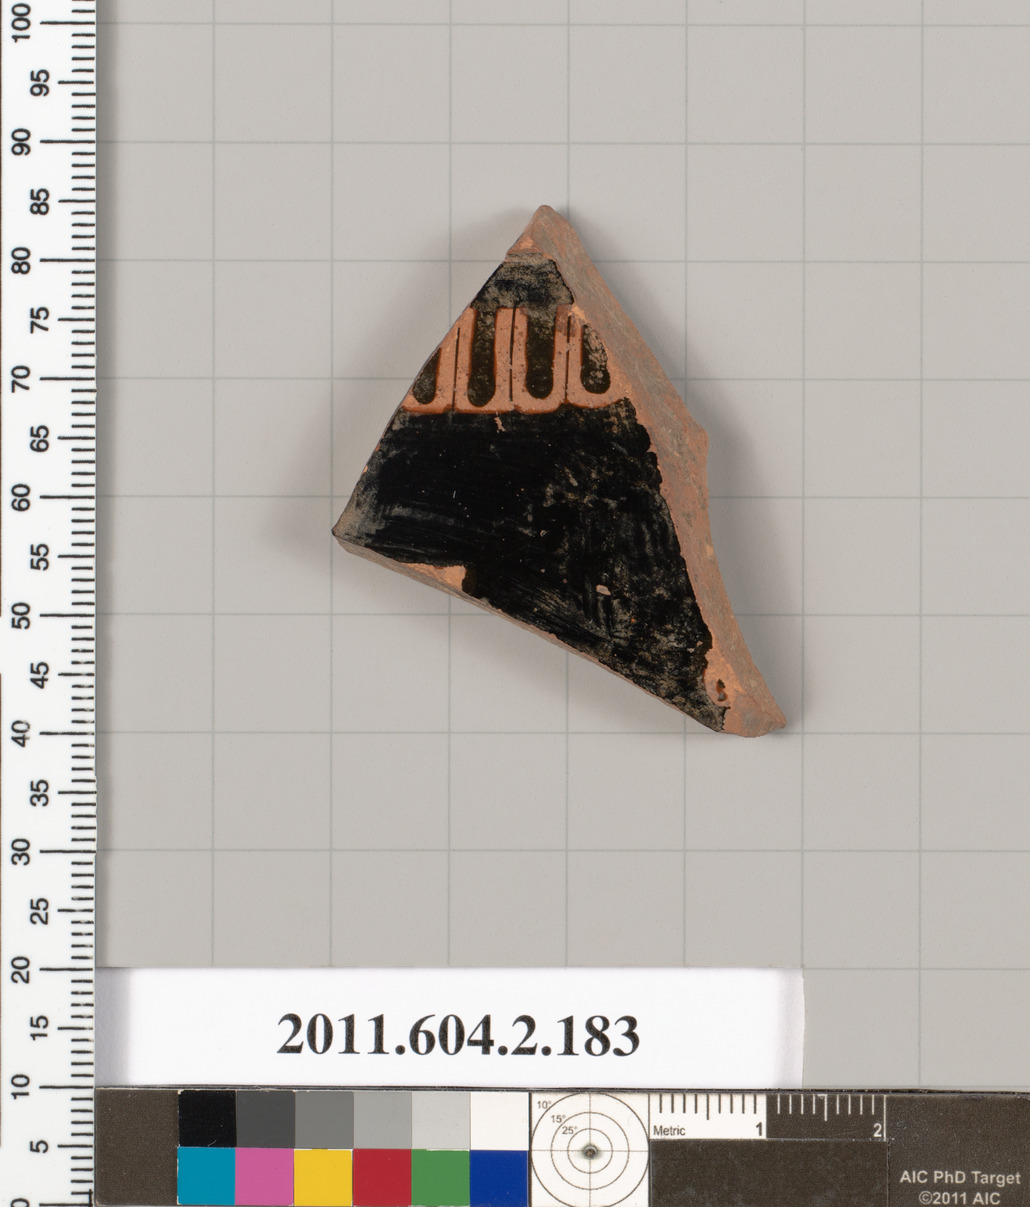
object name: stamnos fragment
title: Terracotta fragment of a stamnos (jar)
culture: greek, attic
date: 475-451 BCE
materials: terracotta